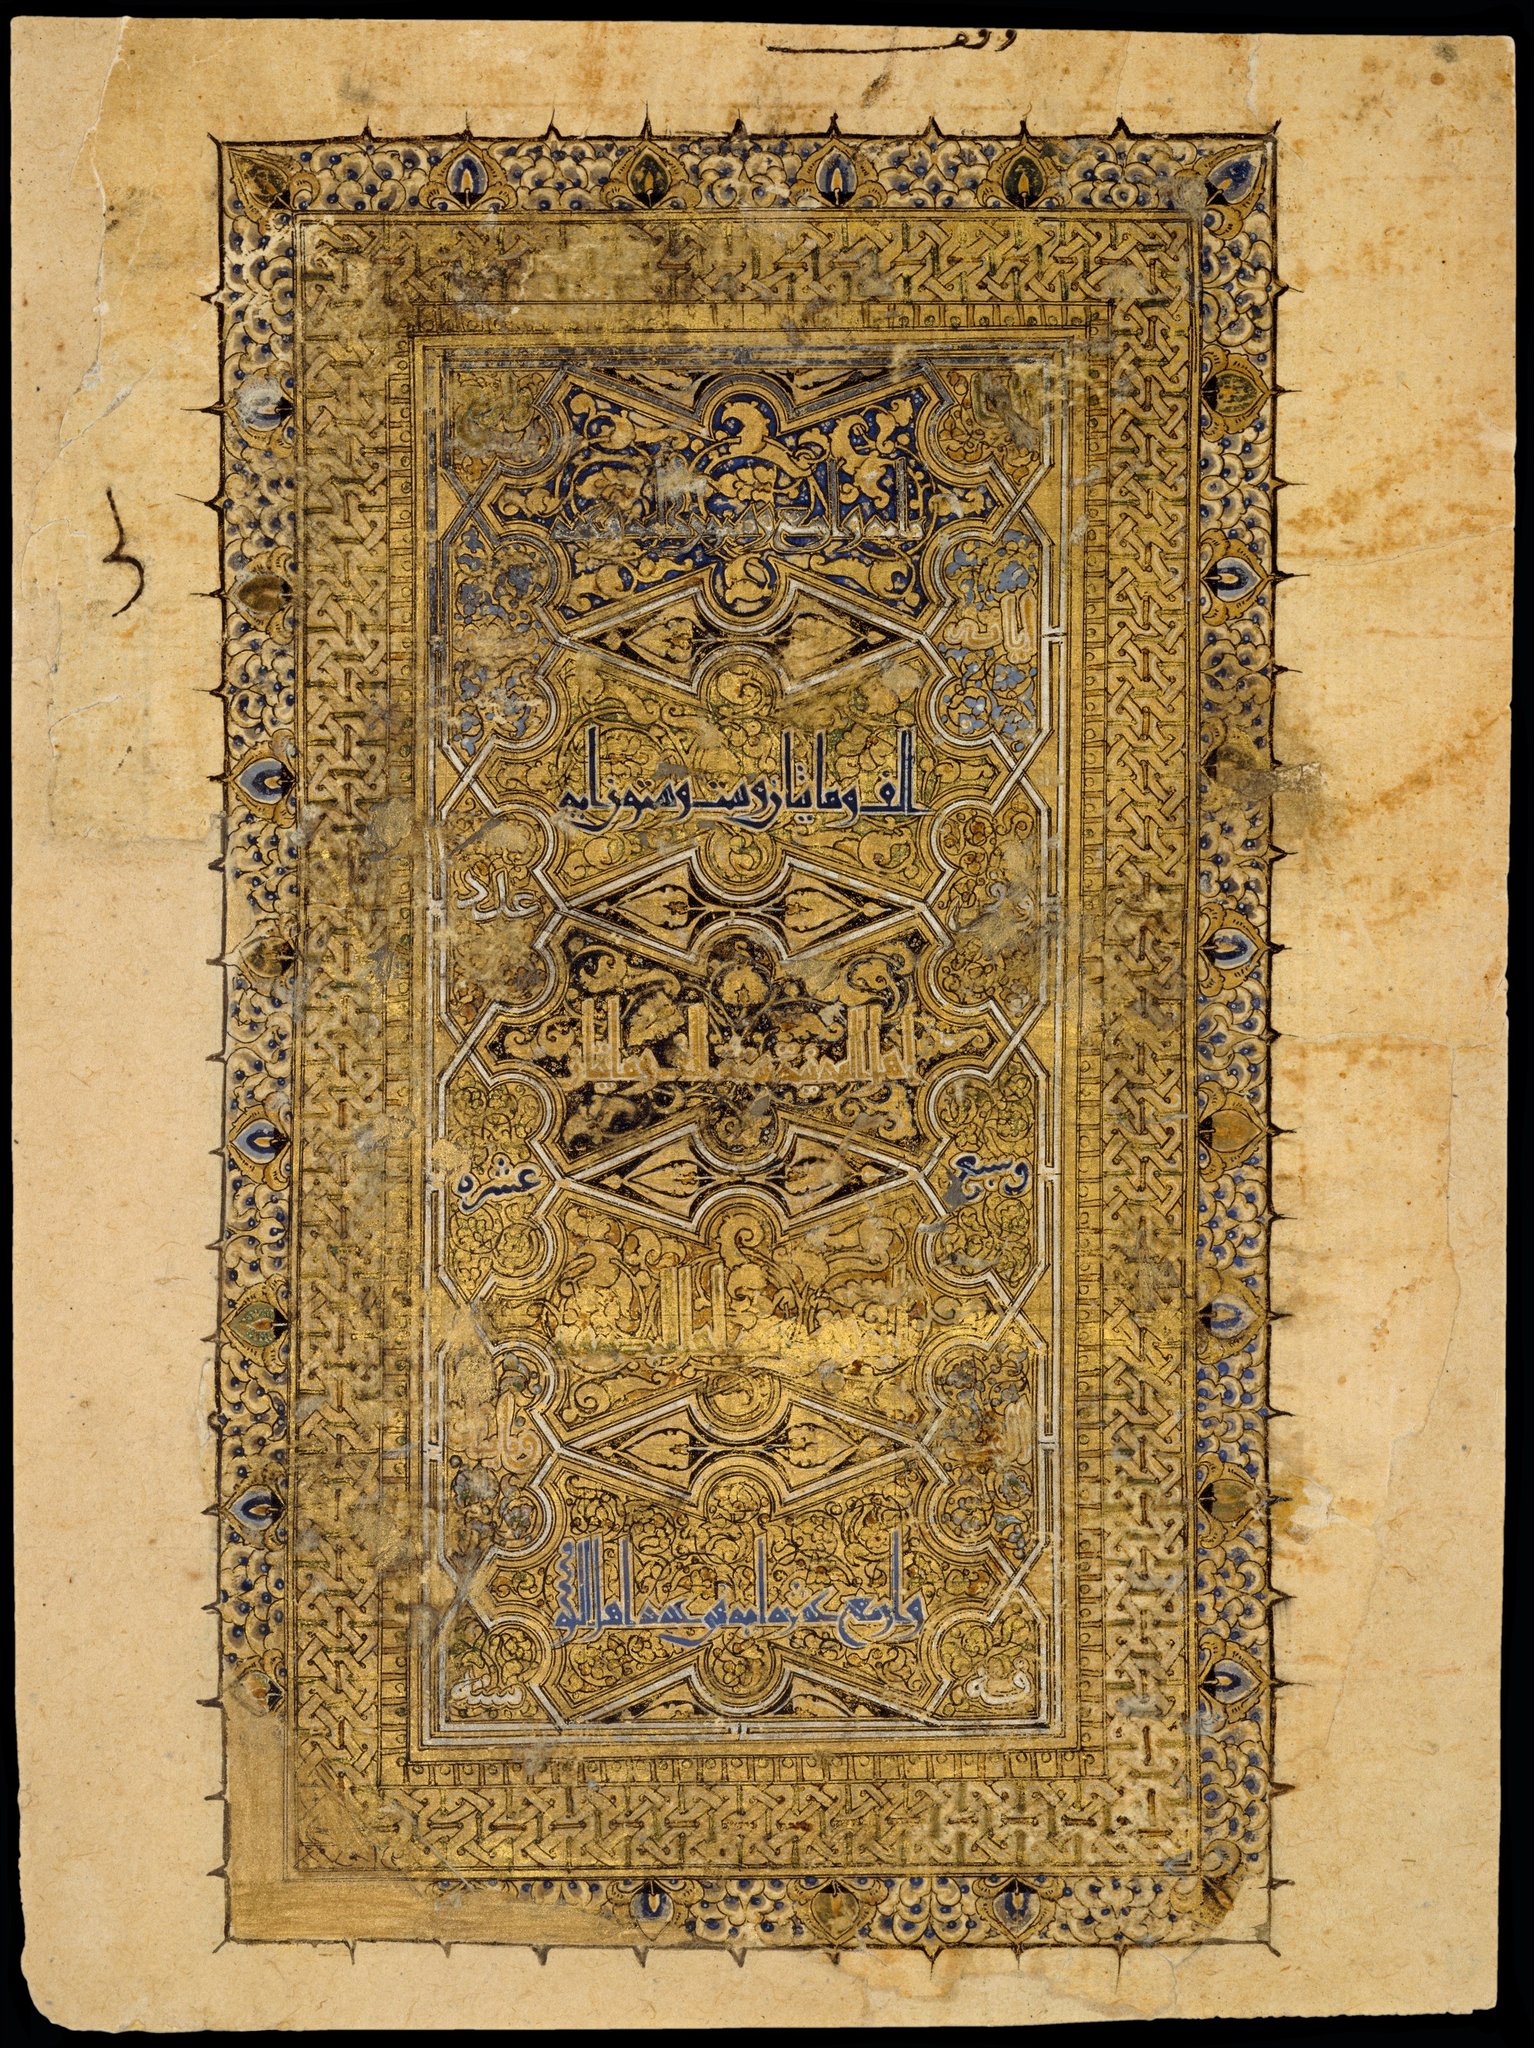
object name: folio from a non illustrated manuscript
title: Folio from a Qur'an Manuscript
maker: muhammad al-zanjani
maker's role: calligrapher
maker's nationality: iranian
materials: gold, ink, paper, watercolor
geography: iran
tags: qur'an